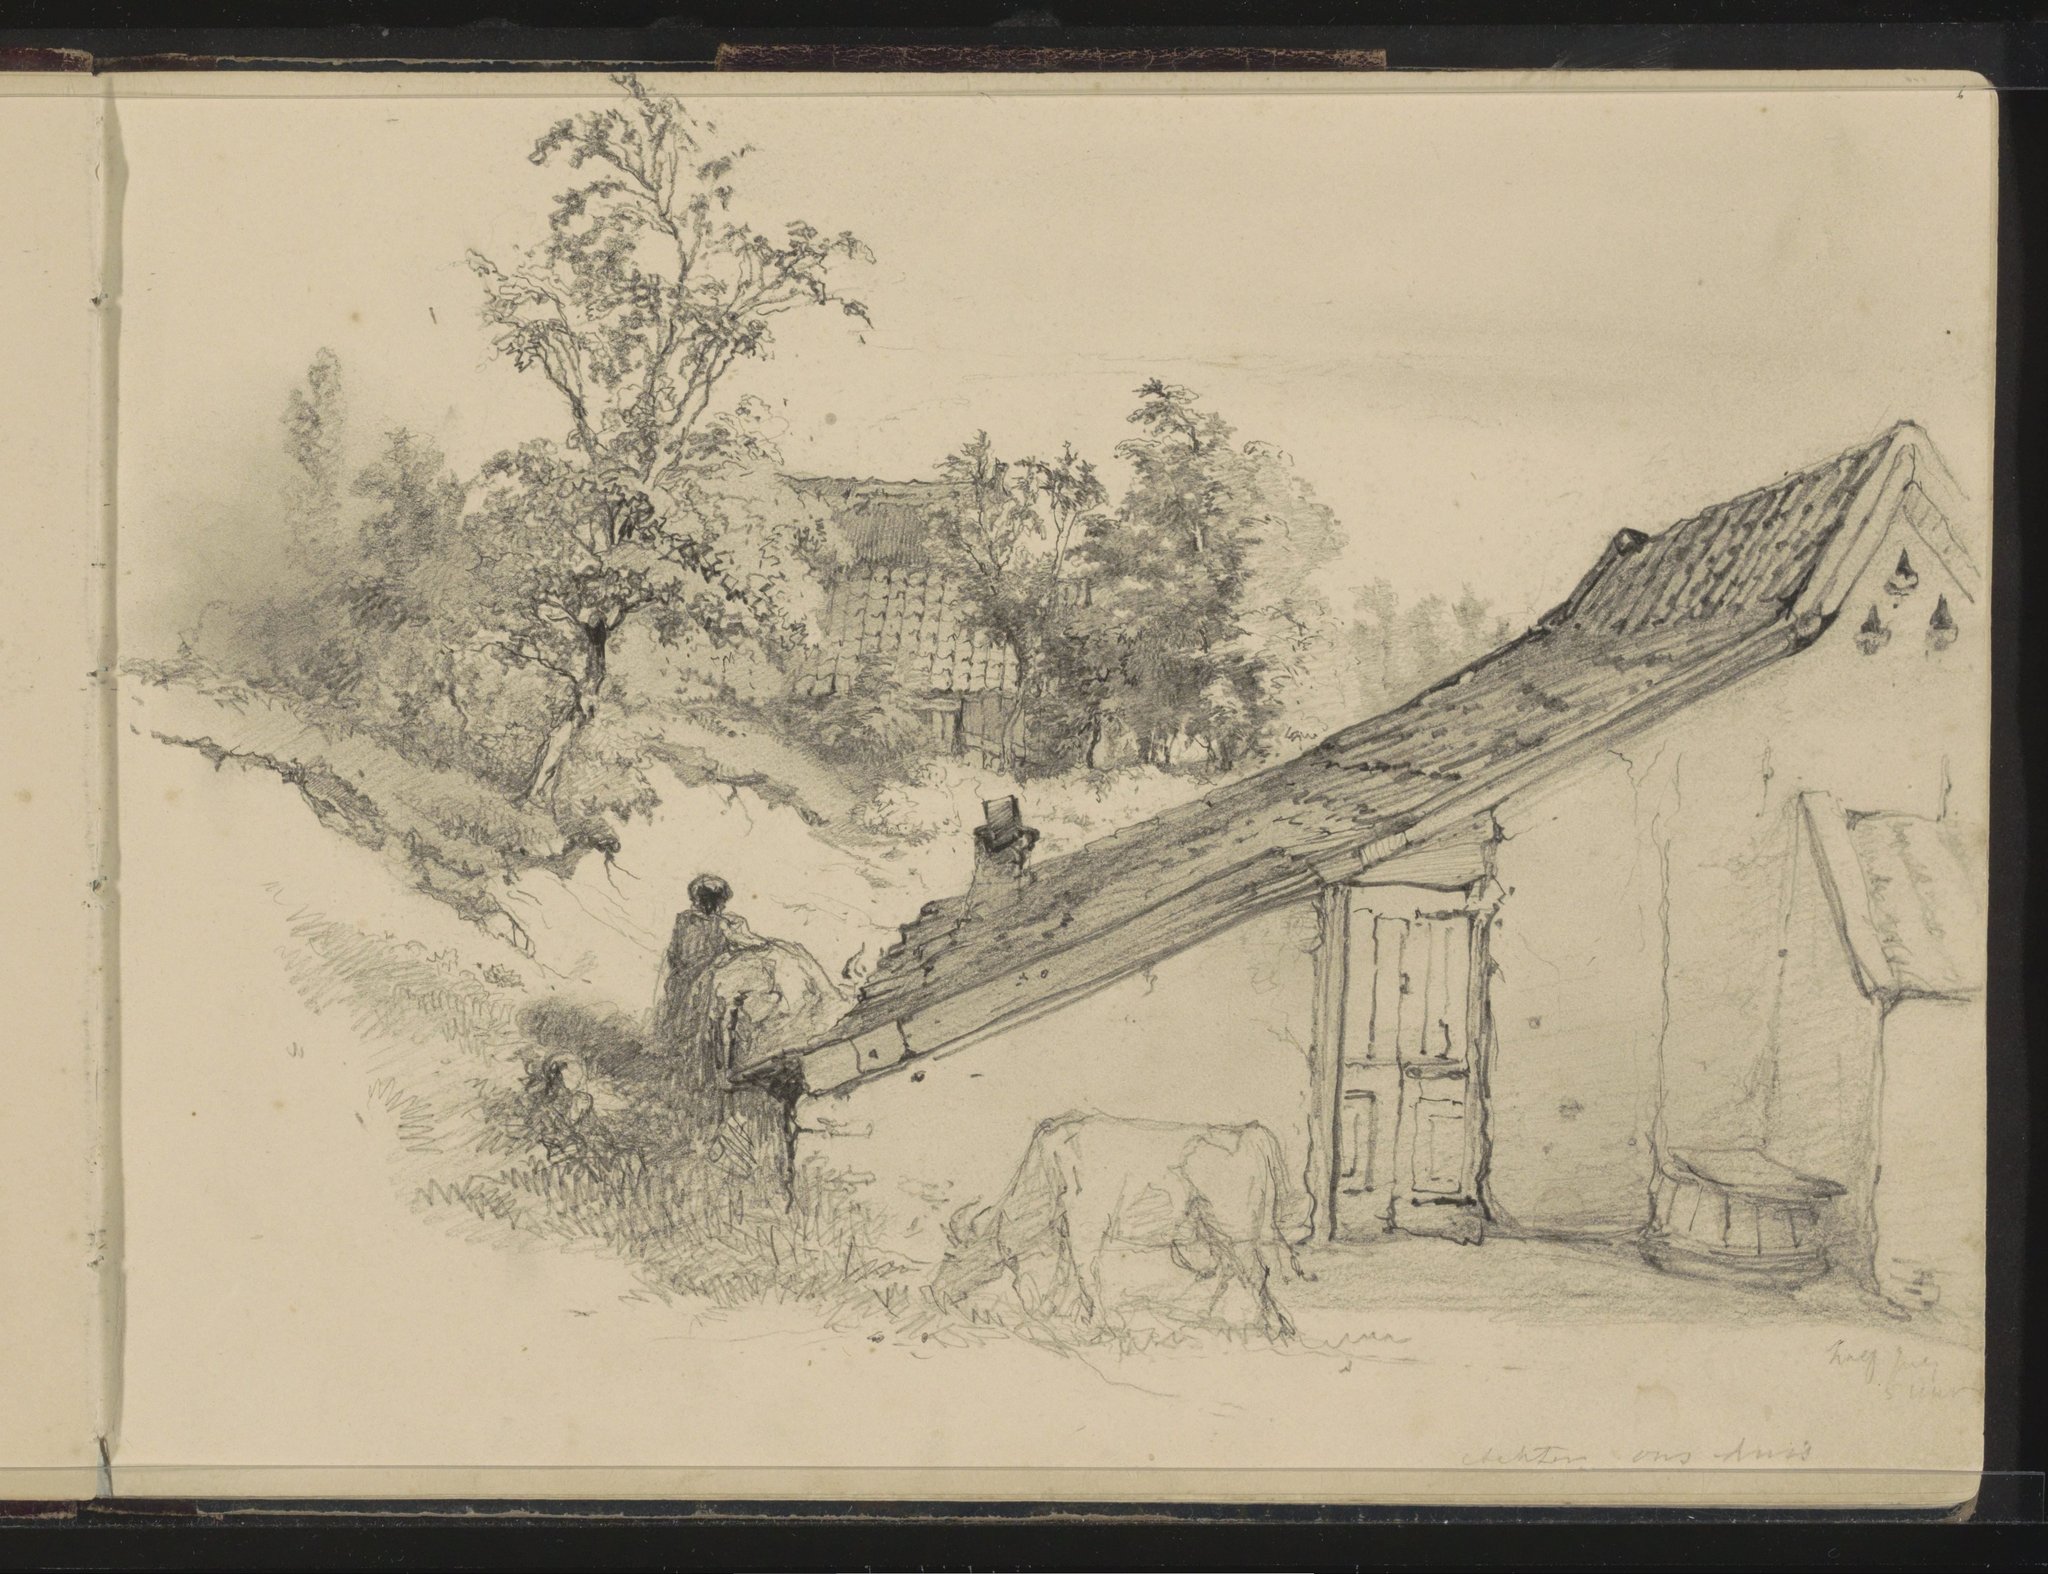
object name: sketchbook leaf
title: Huis in het Zweiersdal te Oosterbeek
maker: maria vos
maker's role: draughtsman, painter, print maker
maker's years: 1824-1906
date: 1864-1865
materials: paper, pencil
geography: oosterbeek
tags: rural housing, e.g. country-house, villa, cottage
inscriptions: date and inscription: ‘half July/ 5 uur/ achter ons huis’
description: Het Zweiersdal ligt achter de Weverstraat waar Vos destijds haar atelier had.